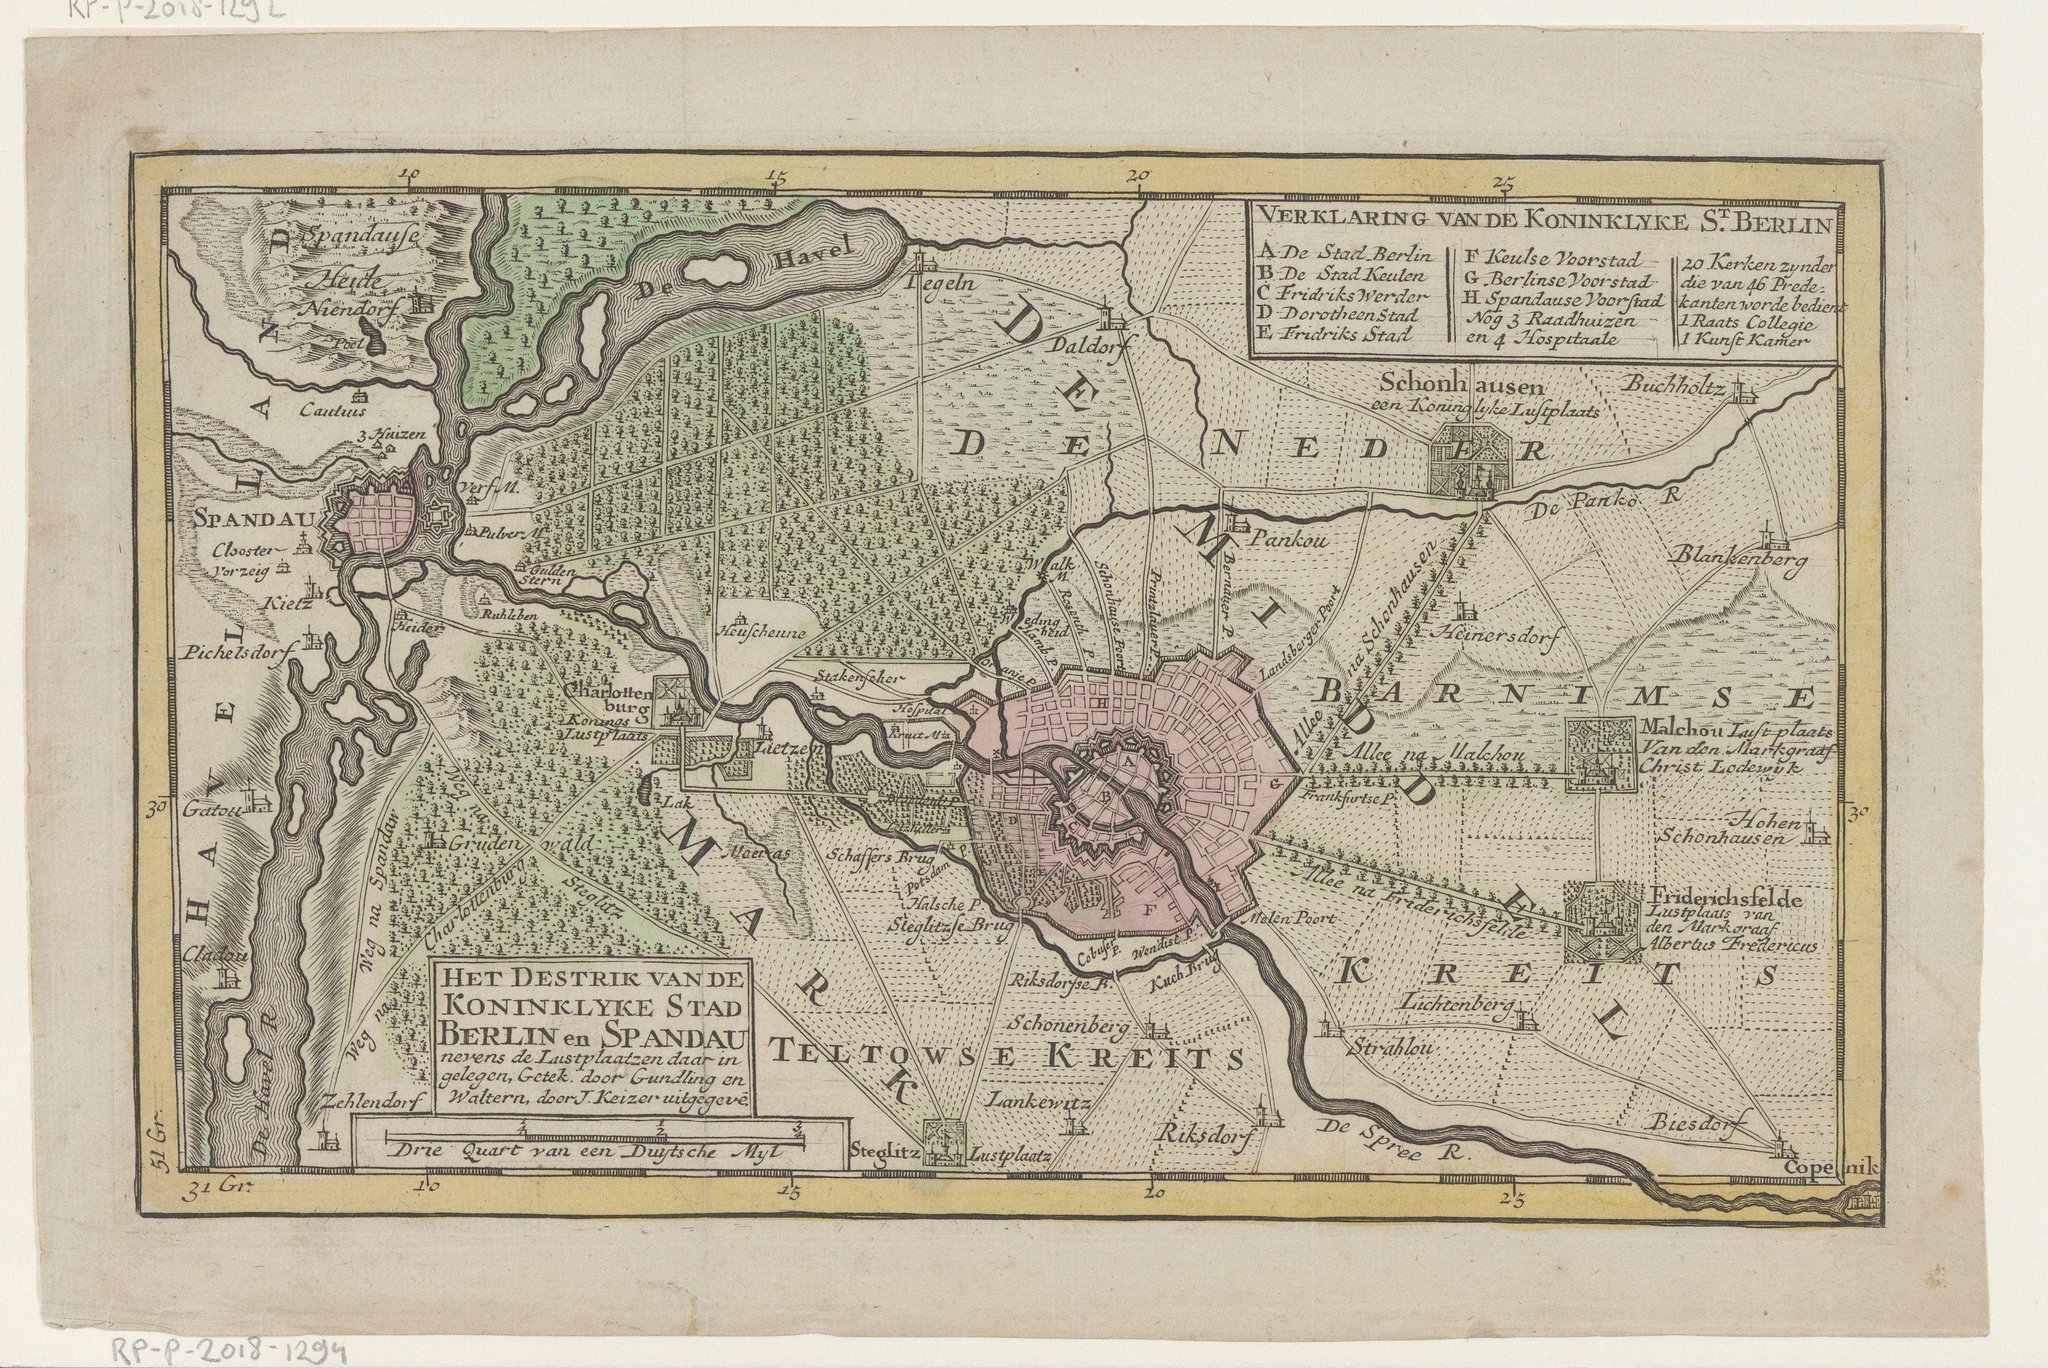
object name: print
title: Het destrik van de koninklyke stad Berlin en Spandau nevens de (...)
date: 1740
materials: paper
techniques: engraving, hand coloring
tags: exchange, bourse, berlin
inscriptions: collector's mark: Lugt 2228